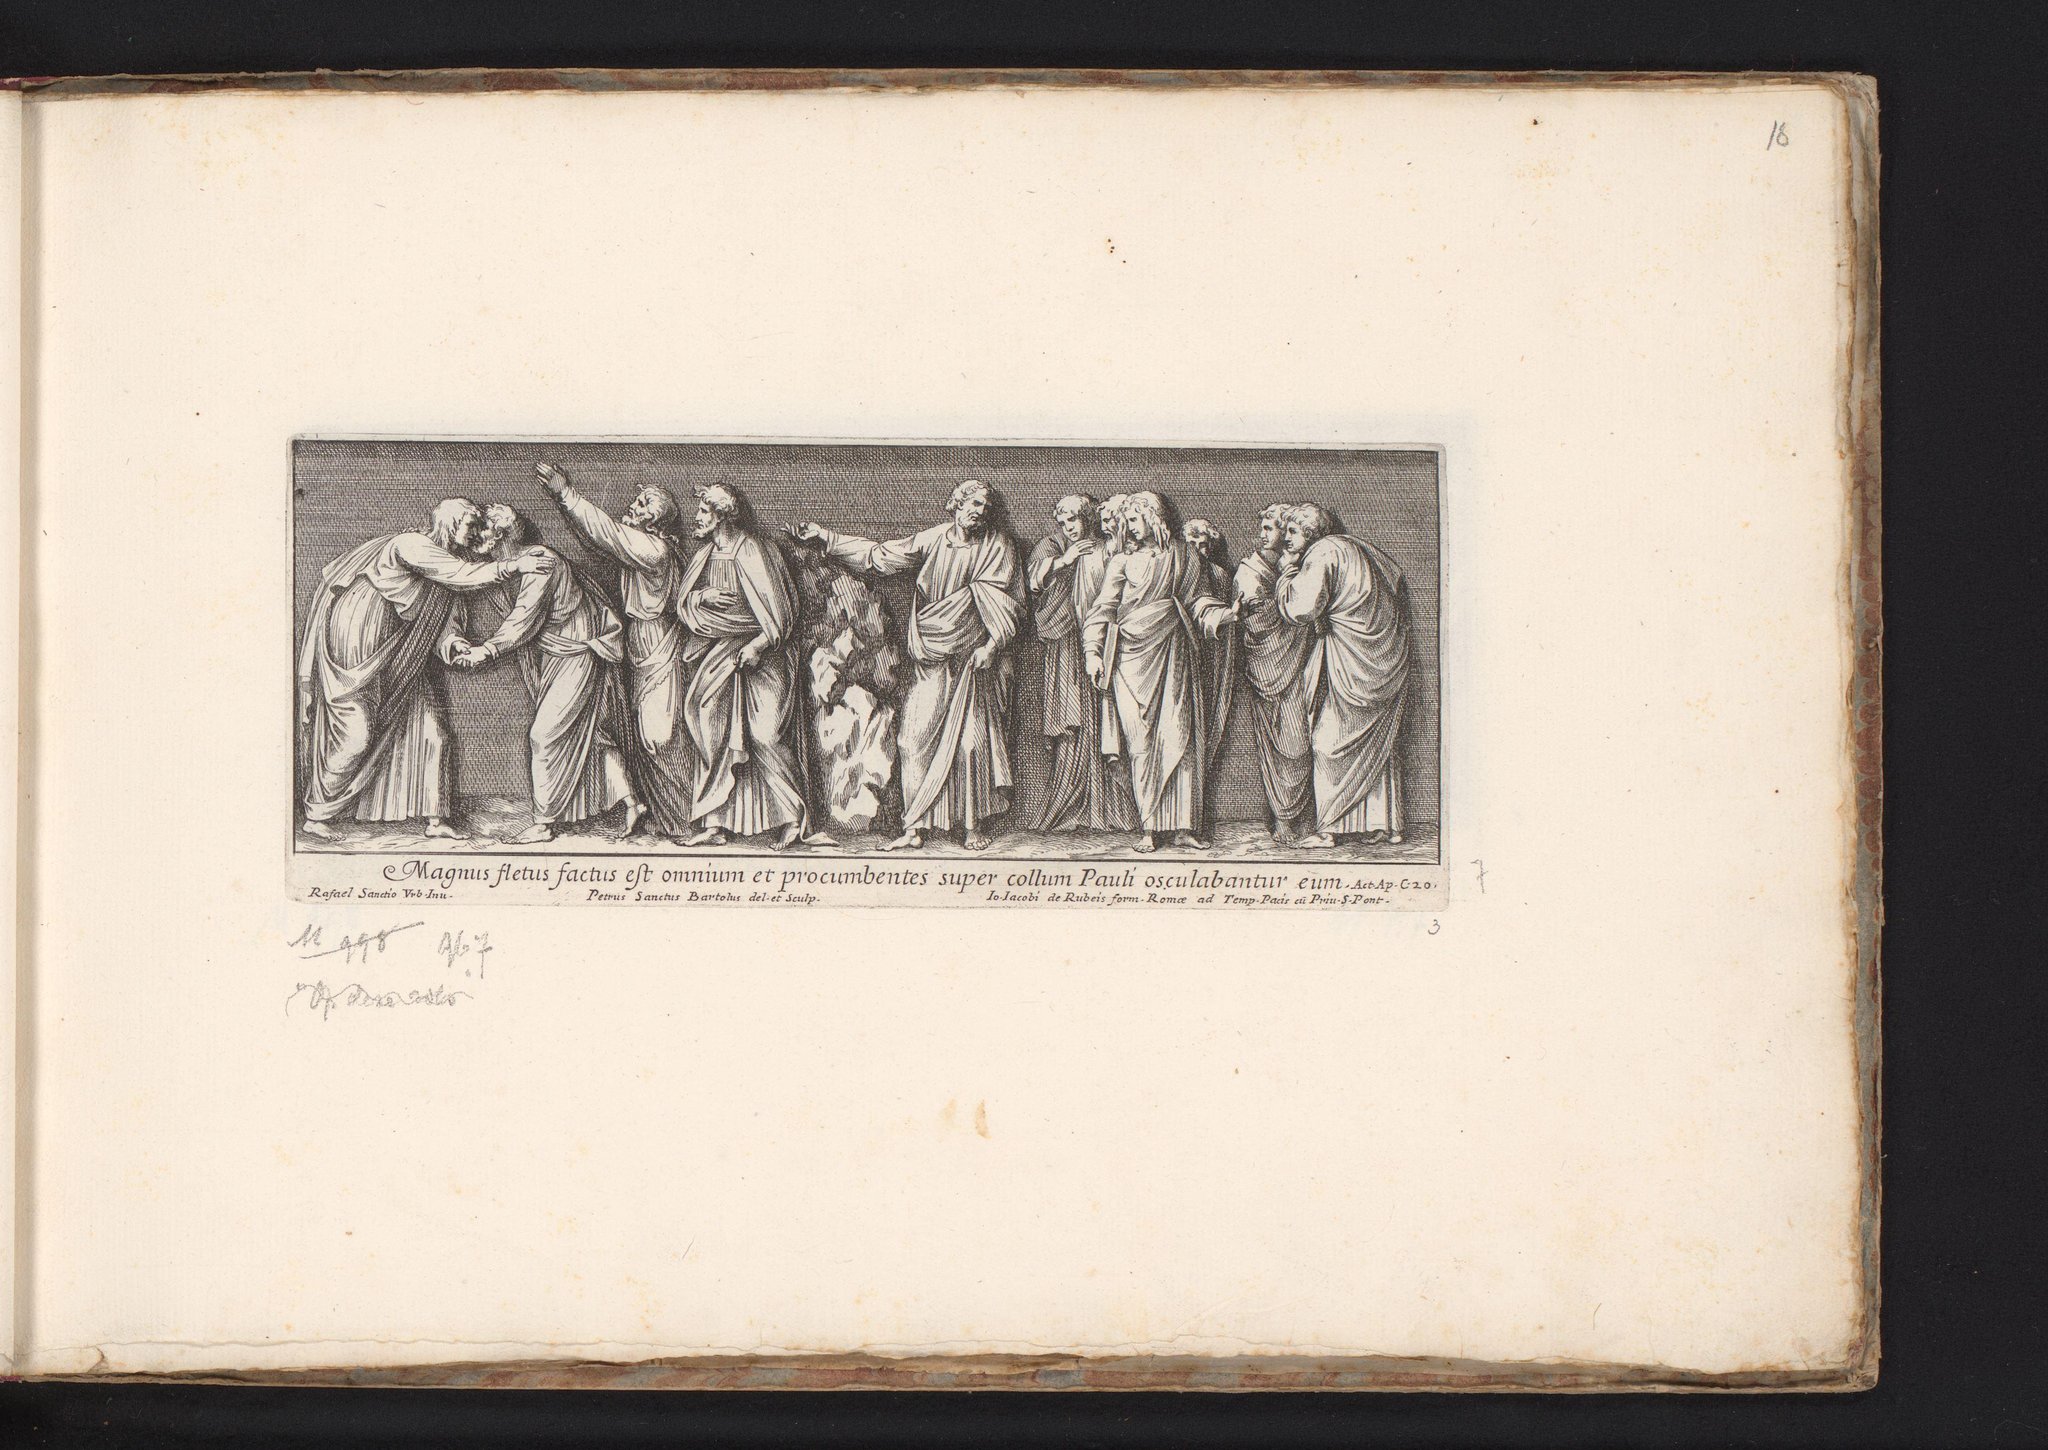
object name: print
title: Afscheid van Paulus in Antiochië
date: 1645-1700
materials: paper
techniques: engraving, etching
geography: vatican city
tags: missionary journeys of paul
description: Prent uit een reeks van 14 prenten (+ titelprent) naar schilderingen door Rafaël in de Stanze di Raffaello in het Apostolisch Paleis in het Vaticaan en naar ontwerpen voor wandtapijten voor de Sixtijnse Kapel door Rafaël. Naar een wandtapijt door Rafaël.